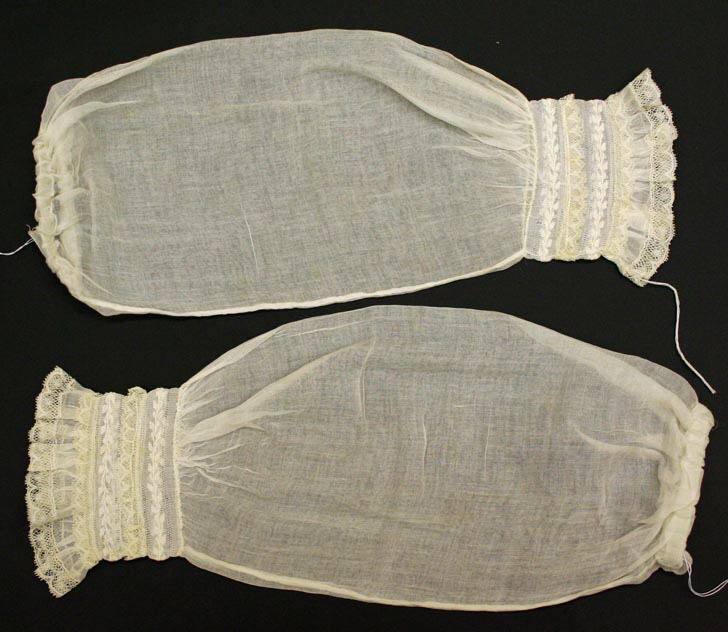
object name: undersleeves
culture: british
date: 1865-1868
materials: cotton